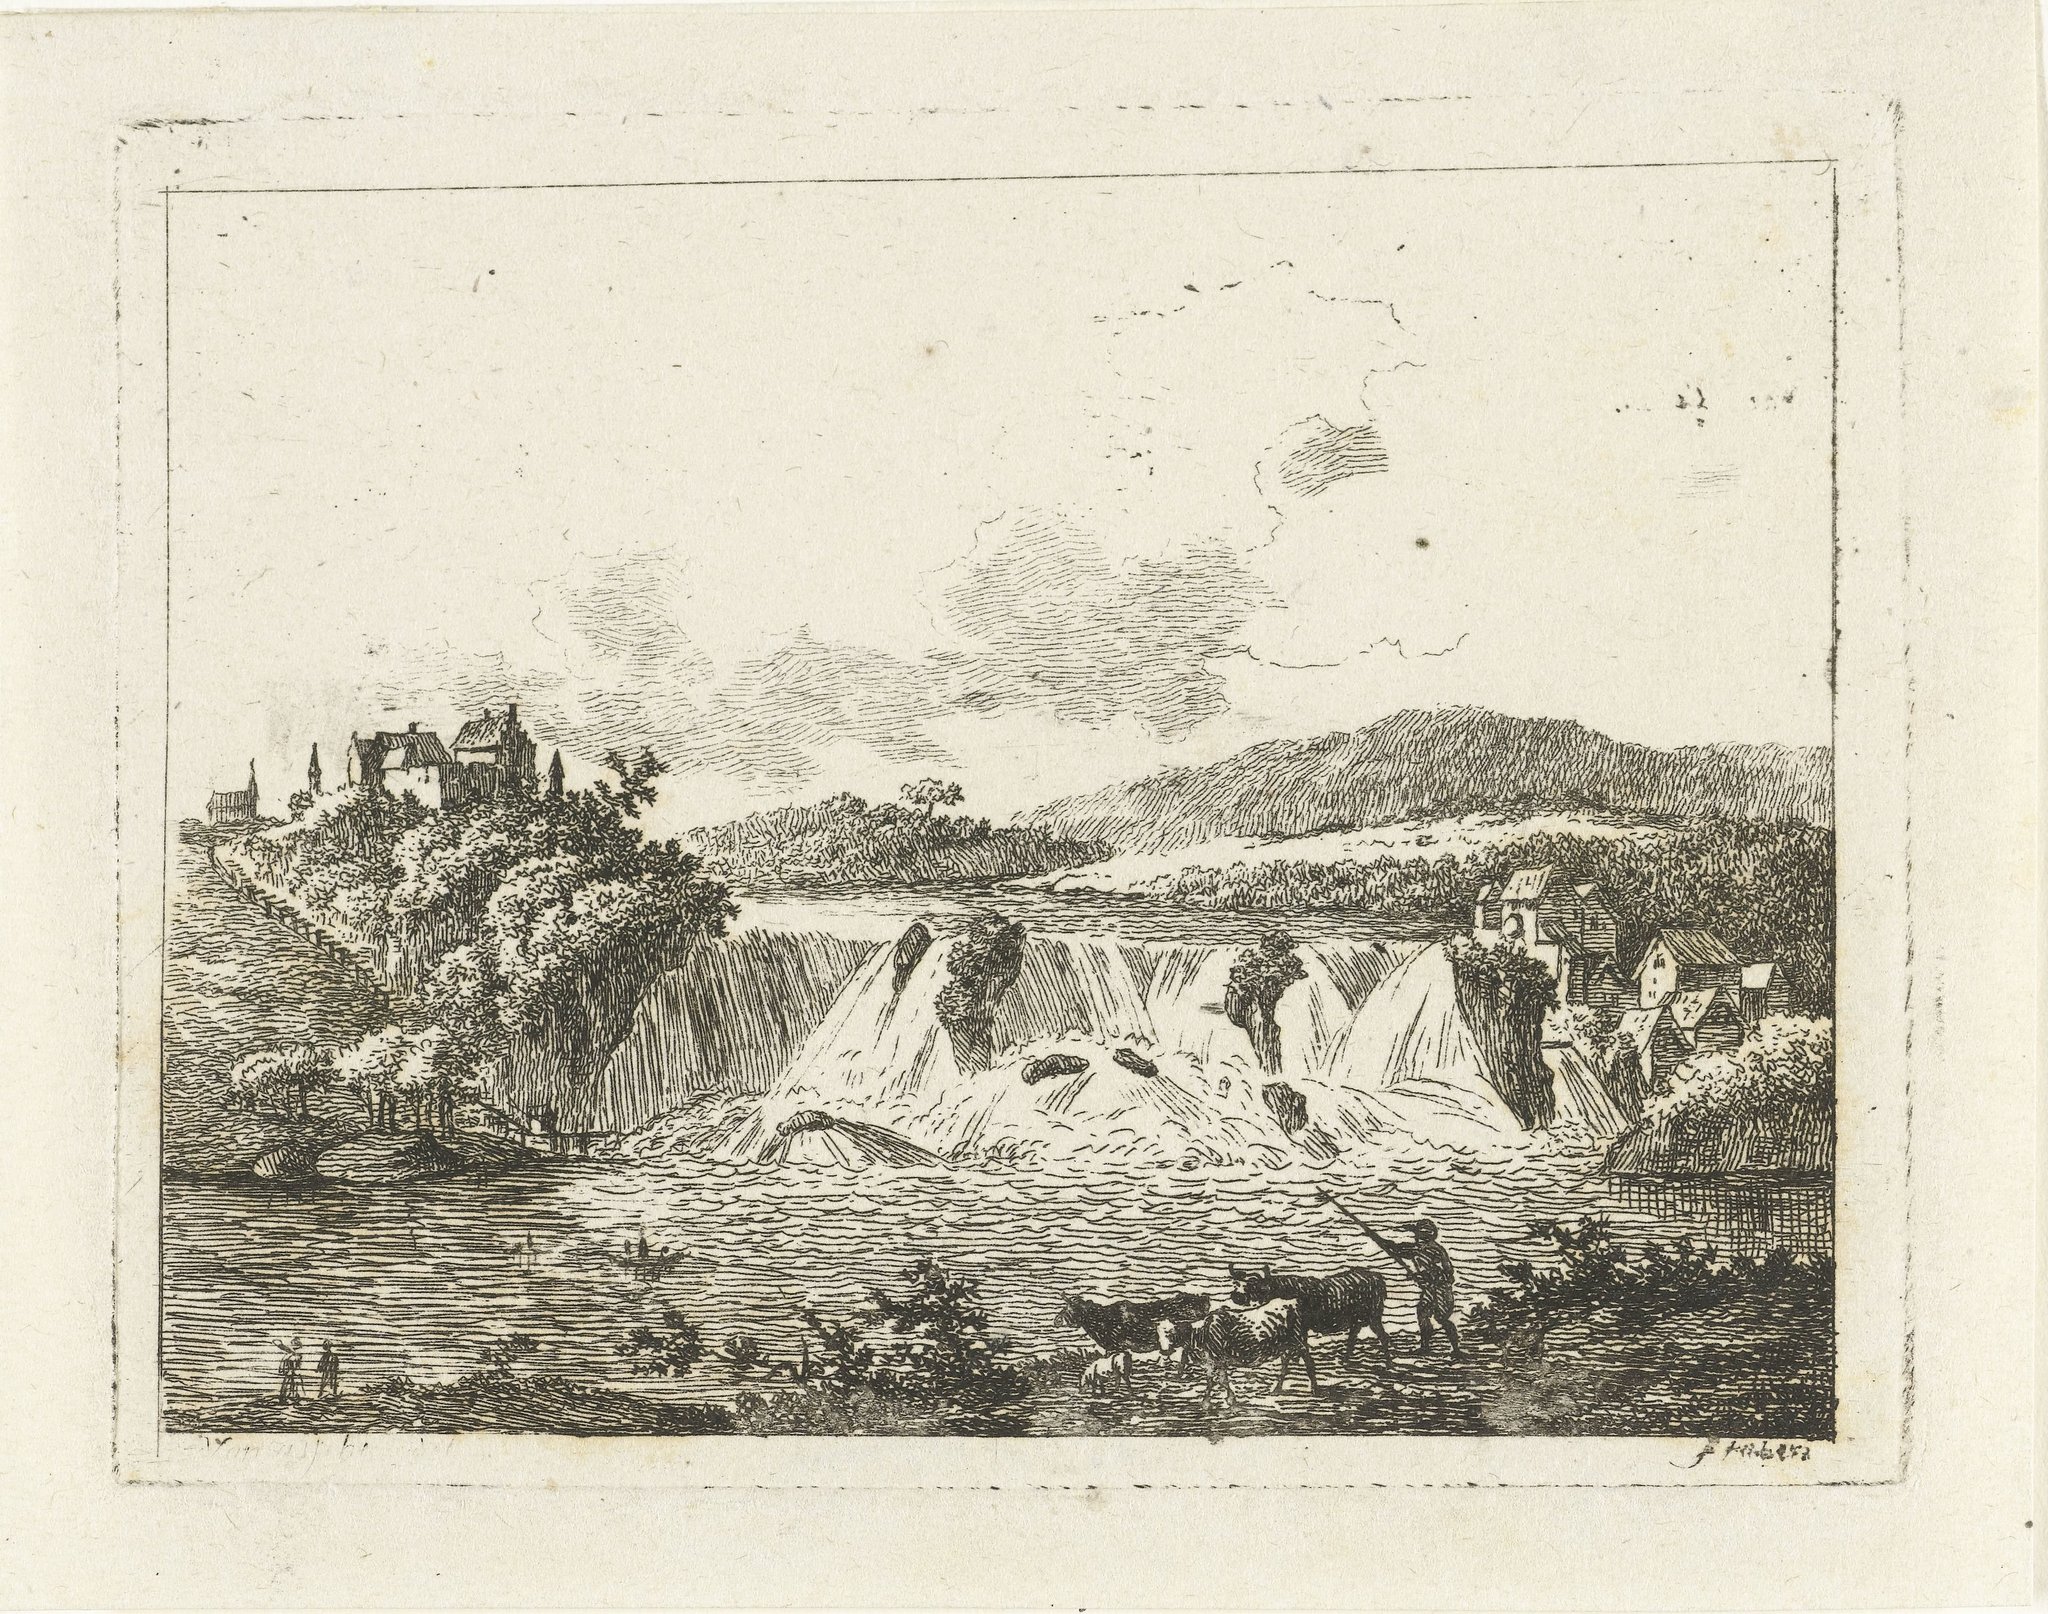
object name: print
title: Landschap met waterval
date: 1806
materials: paper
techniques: etching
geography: brussels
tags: waterfall (+ landscape with figures, staffage)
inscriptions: collector's mark: Lugt 2228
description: Gezicht op een grote waterval met aan weerszijden huizen. Op de voorgrond een herder met zijn kudde.